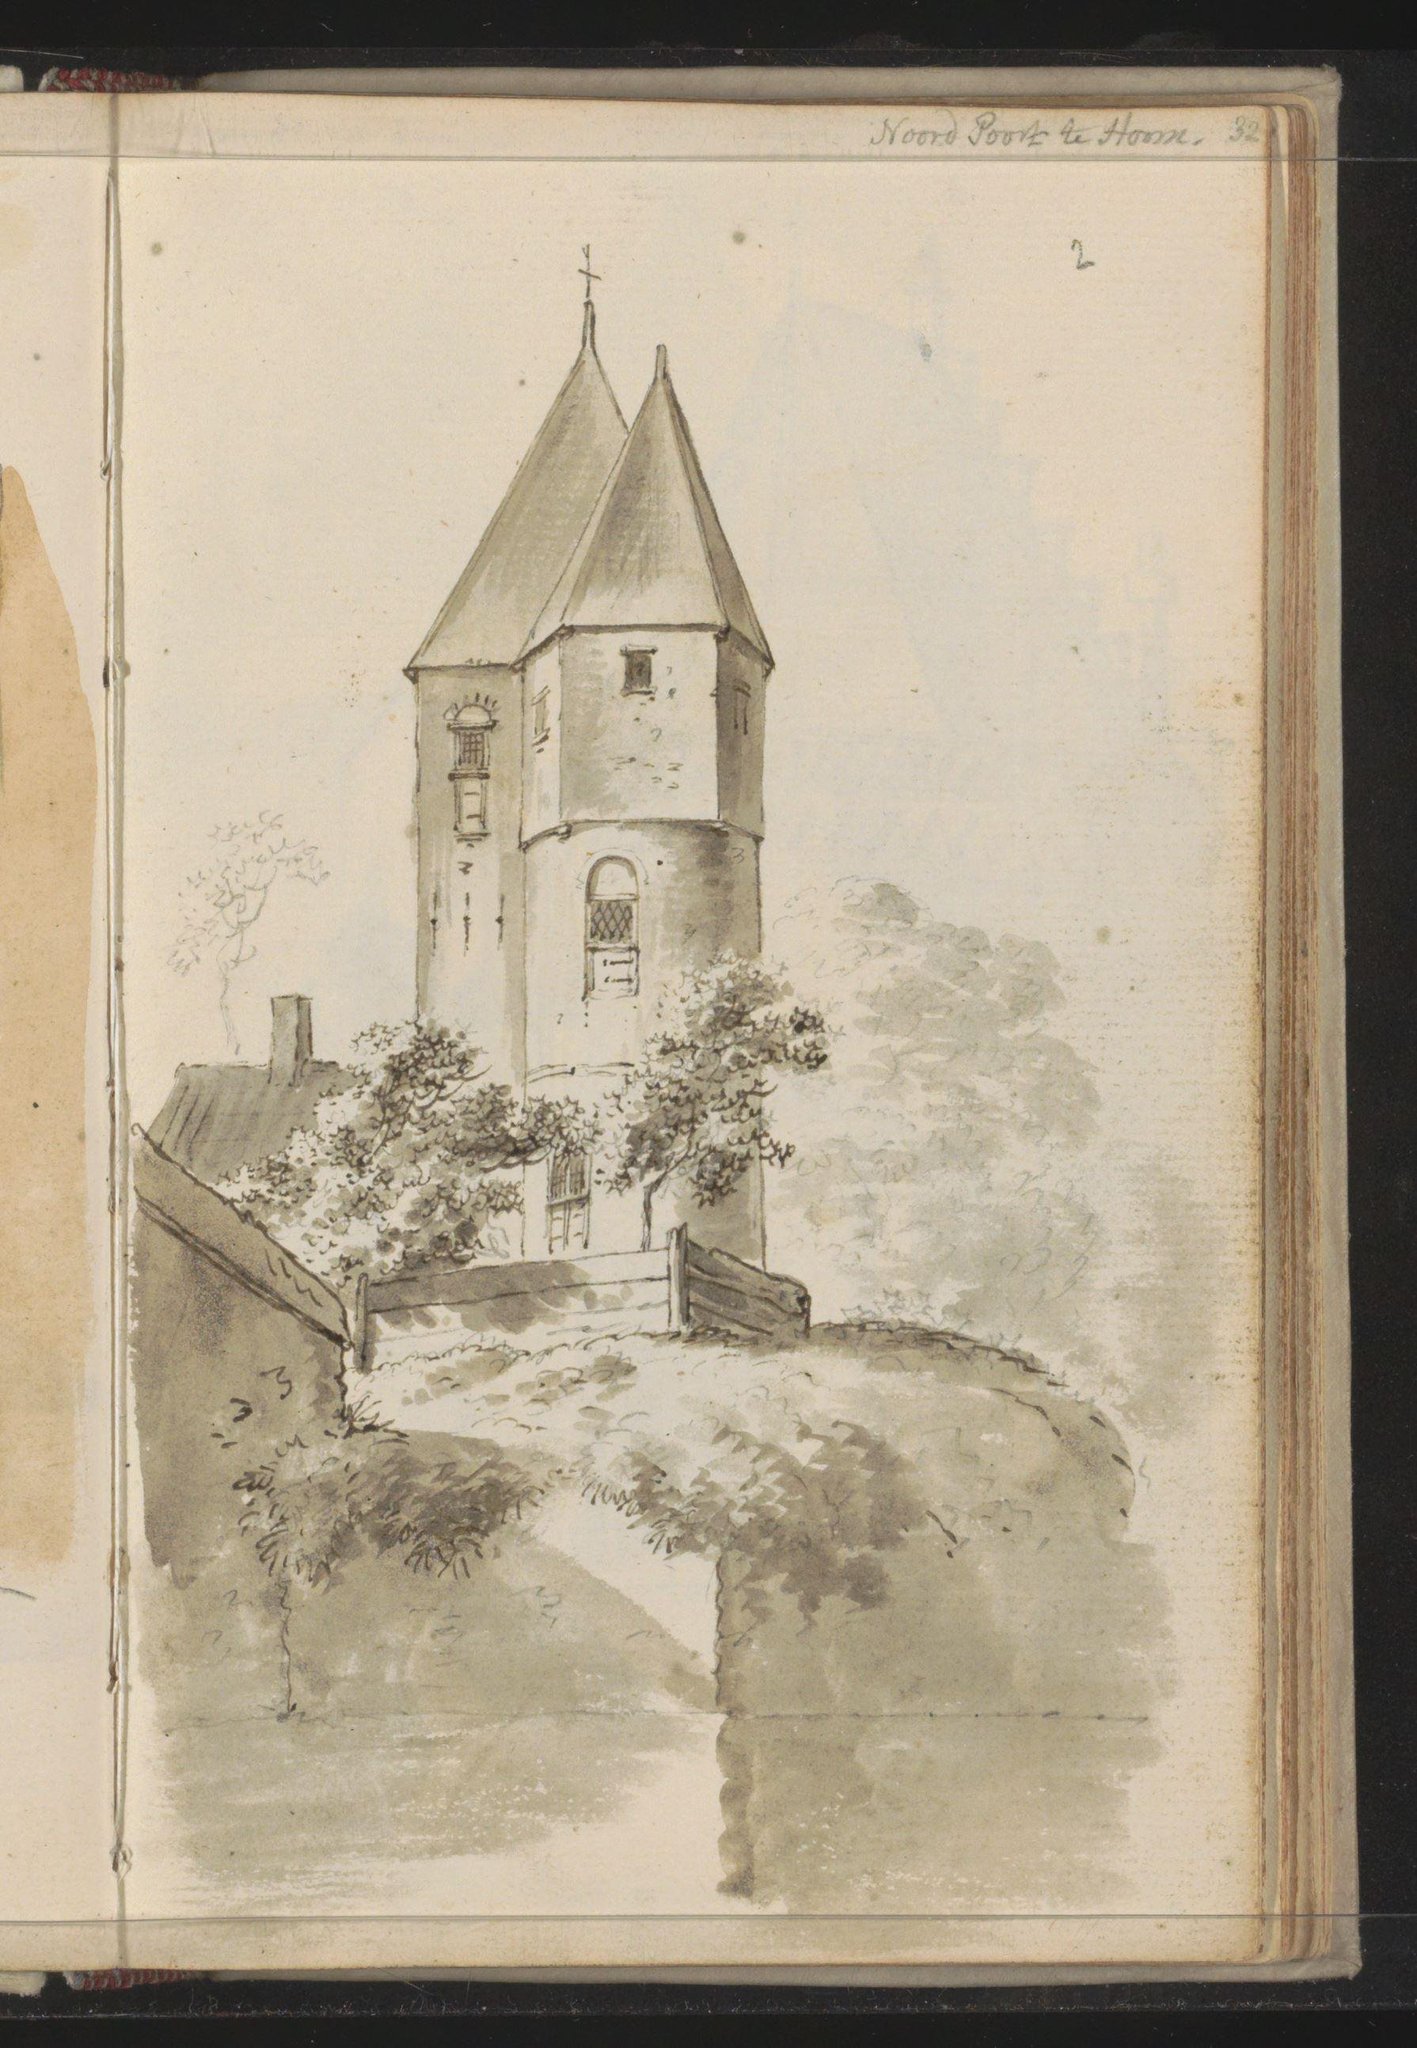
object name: sketchbook leaf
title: Torens van de Noorderpoort te Hoorn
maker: johannes huibert prins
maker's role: draughtsman, painter, print maker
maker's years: 1757-1806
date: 1783-1797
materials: ink, paper, pencil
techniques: brush, pen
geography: hoorn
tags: gate, entrance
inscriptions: number: ‘2’, annotation: ‘Noord Poort te Hoorn.’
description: Pagina 32 uit een schetsboek met 175 pagina's.